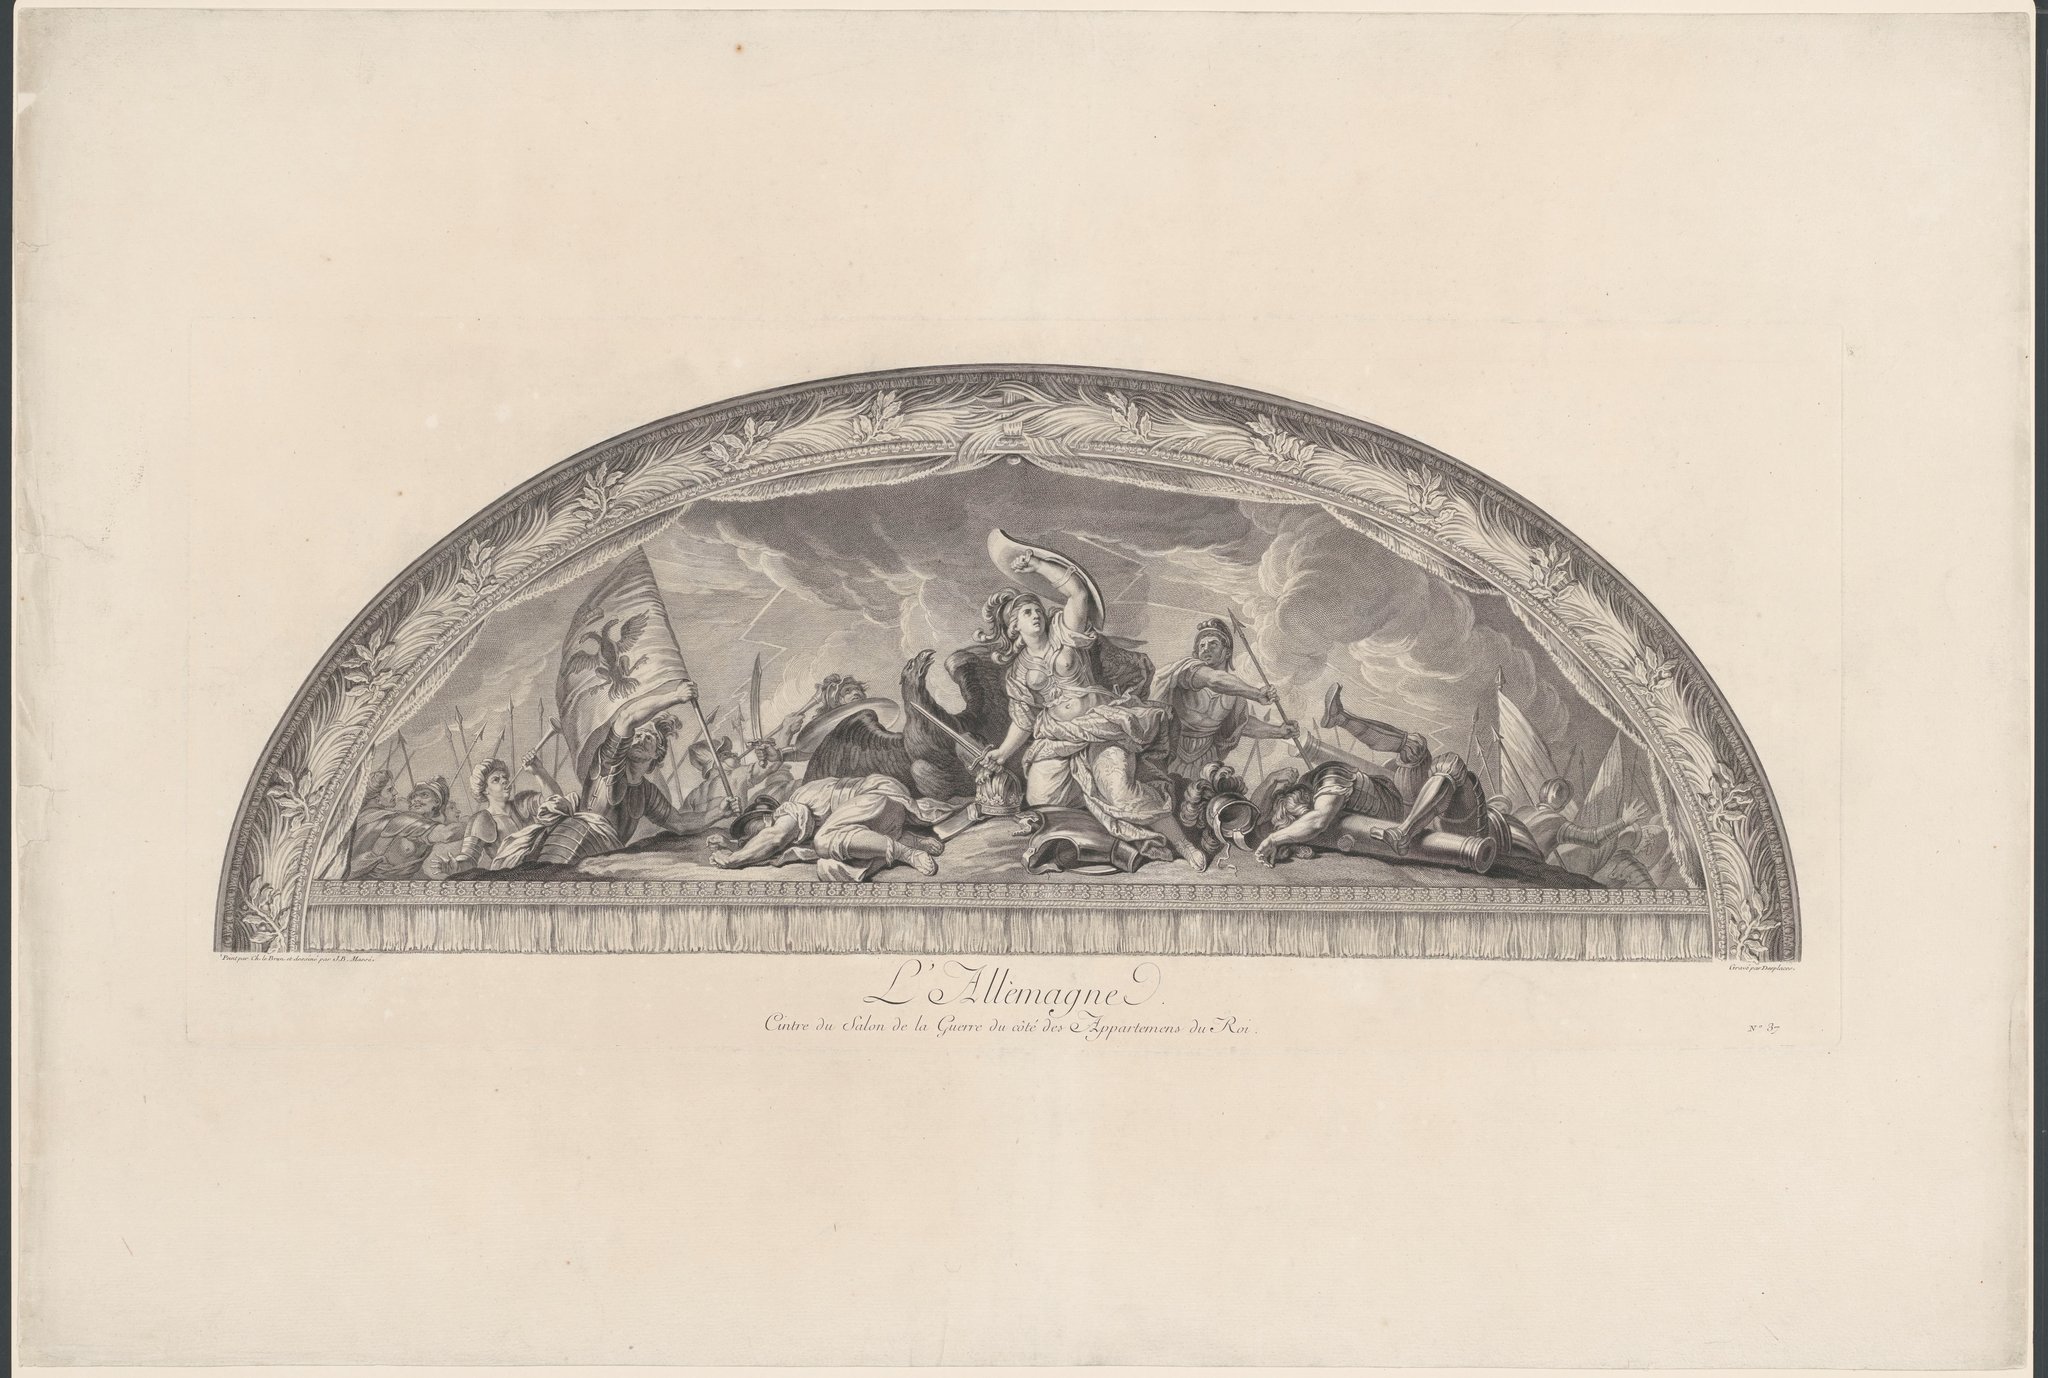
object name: print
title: Plafondschildering in de Spiegelzaal van Kasteel Versailles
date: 1752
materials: paper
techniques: engraving, etching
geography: paris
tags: personifications of countries, nations, states, districts, etc.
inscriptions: number: ‘No 37’